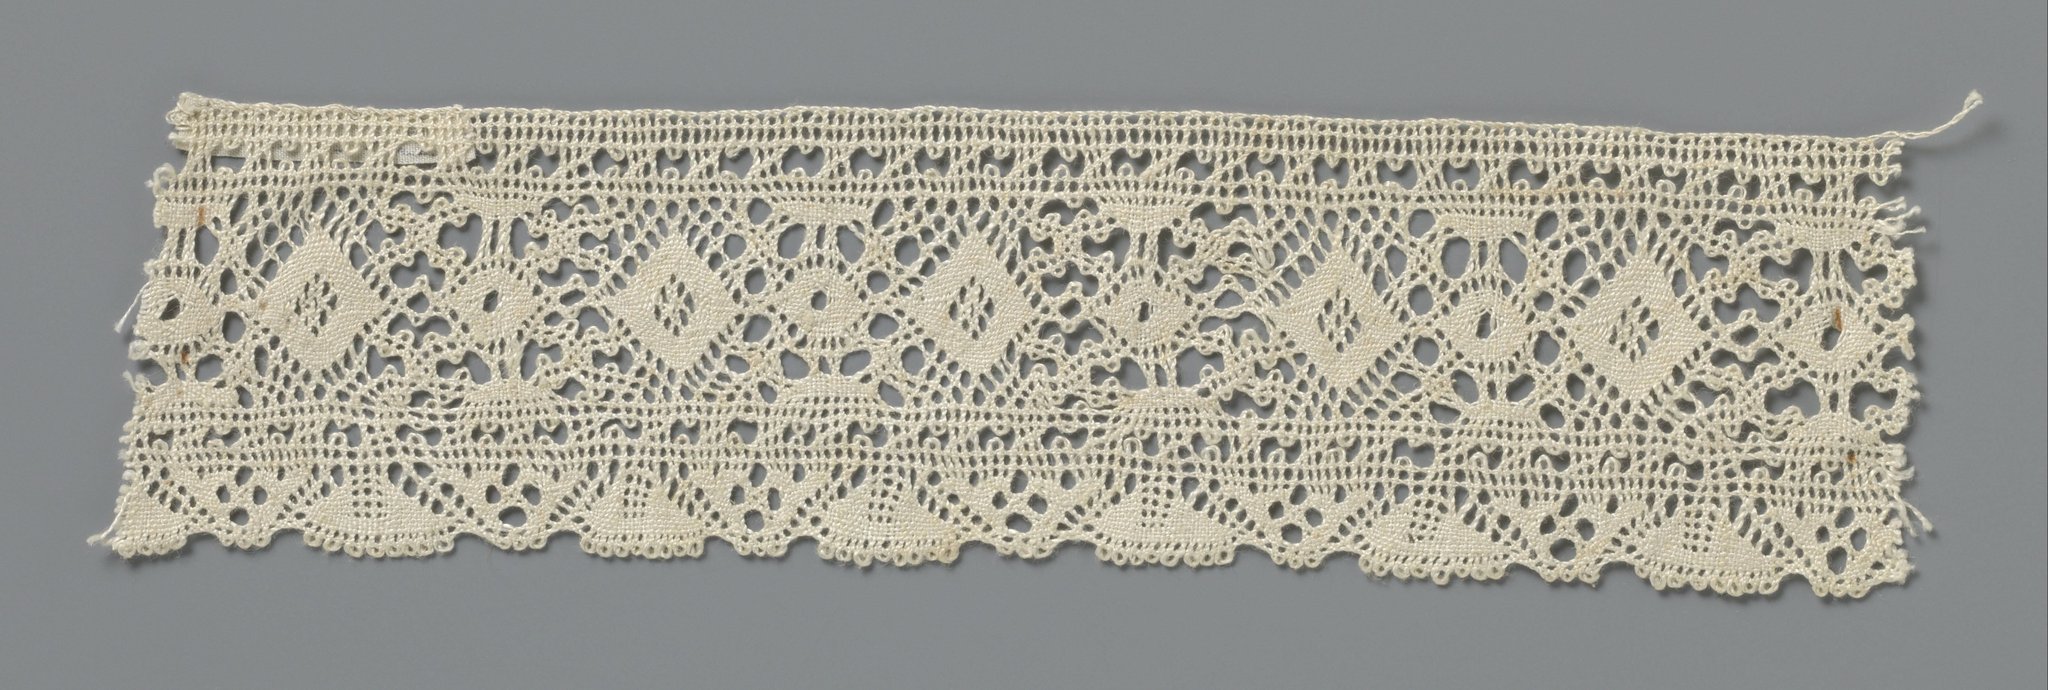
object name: strip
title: Strook kloskant met ruiten en spitsovalen en een rand met driehoekjes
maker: Anonymous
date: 1800-1899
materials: linen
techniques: lace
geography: skåne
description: Strook naturelkleurige kloskant, Zweedse kant. De strook is met spelden op een lichtblauw karton bevestigd, met zeven andere stroken. Bovenaan het karton staat "Laces From Skåne. Sweden." geschreven en onder de strook staat "From Tosterup". Tosterup is een kasteel in Skåne, dat in het zuiden van Zweden ligt. Het zich herhalende patroon bestaat uit een ruit afgewisseld door een spitsovaal. Langs de onderzijde vormen aan elkaar geschakelde driehoekjes een sierband. De motieven zijn gemaakt in linnenslag met uitsparingen. De bovenzijde van de strook is recht afgewerkt. De rechte onderzijde is afgewerkt met afwisselend een serie van acht en een serie van drie picots met steeds een kleine onderbreking ertussen.